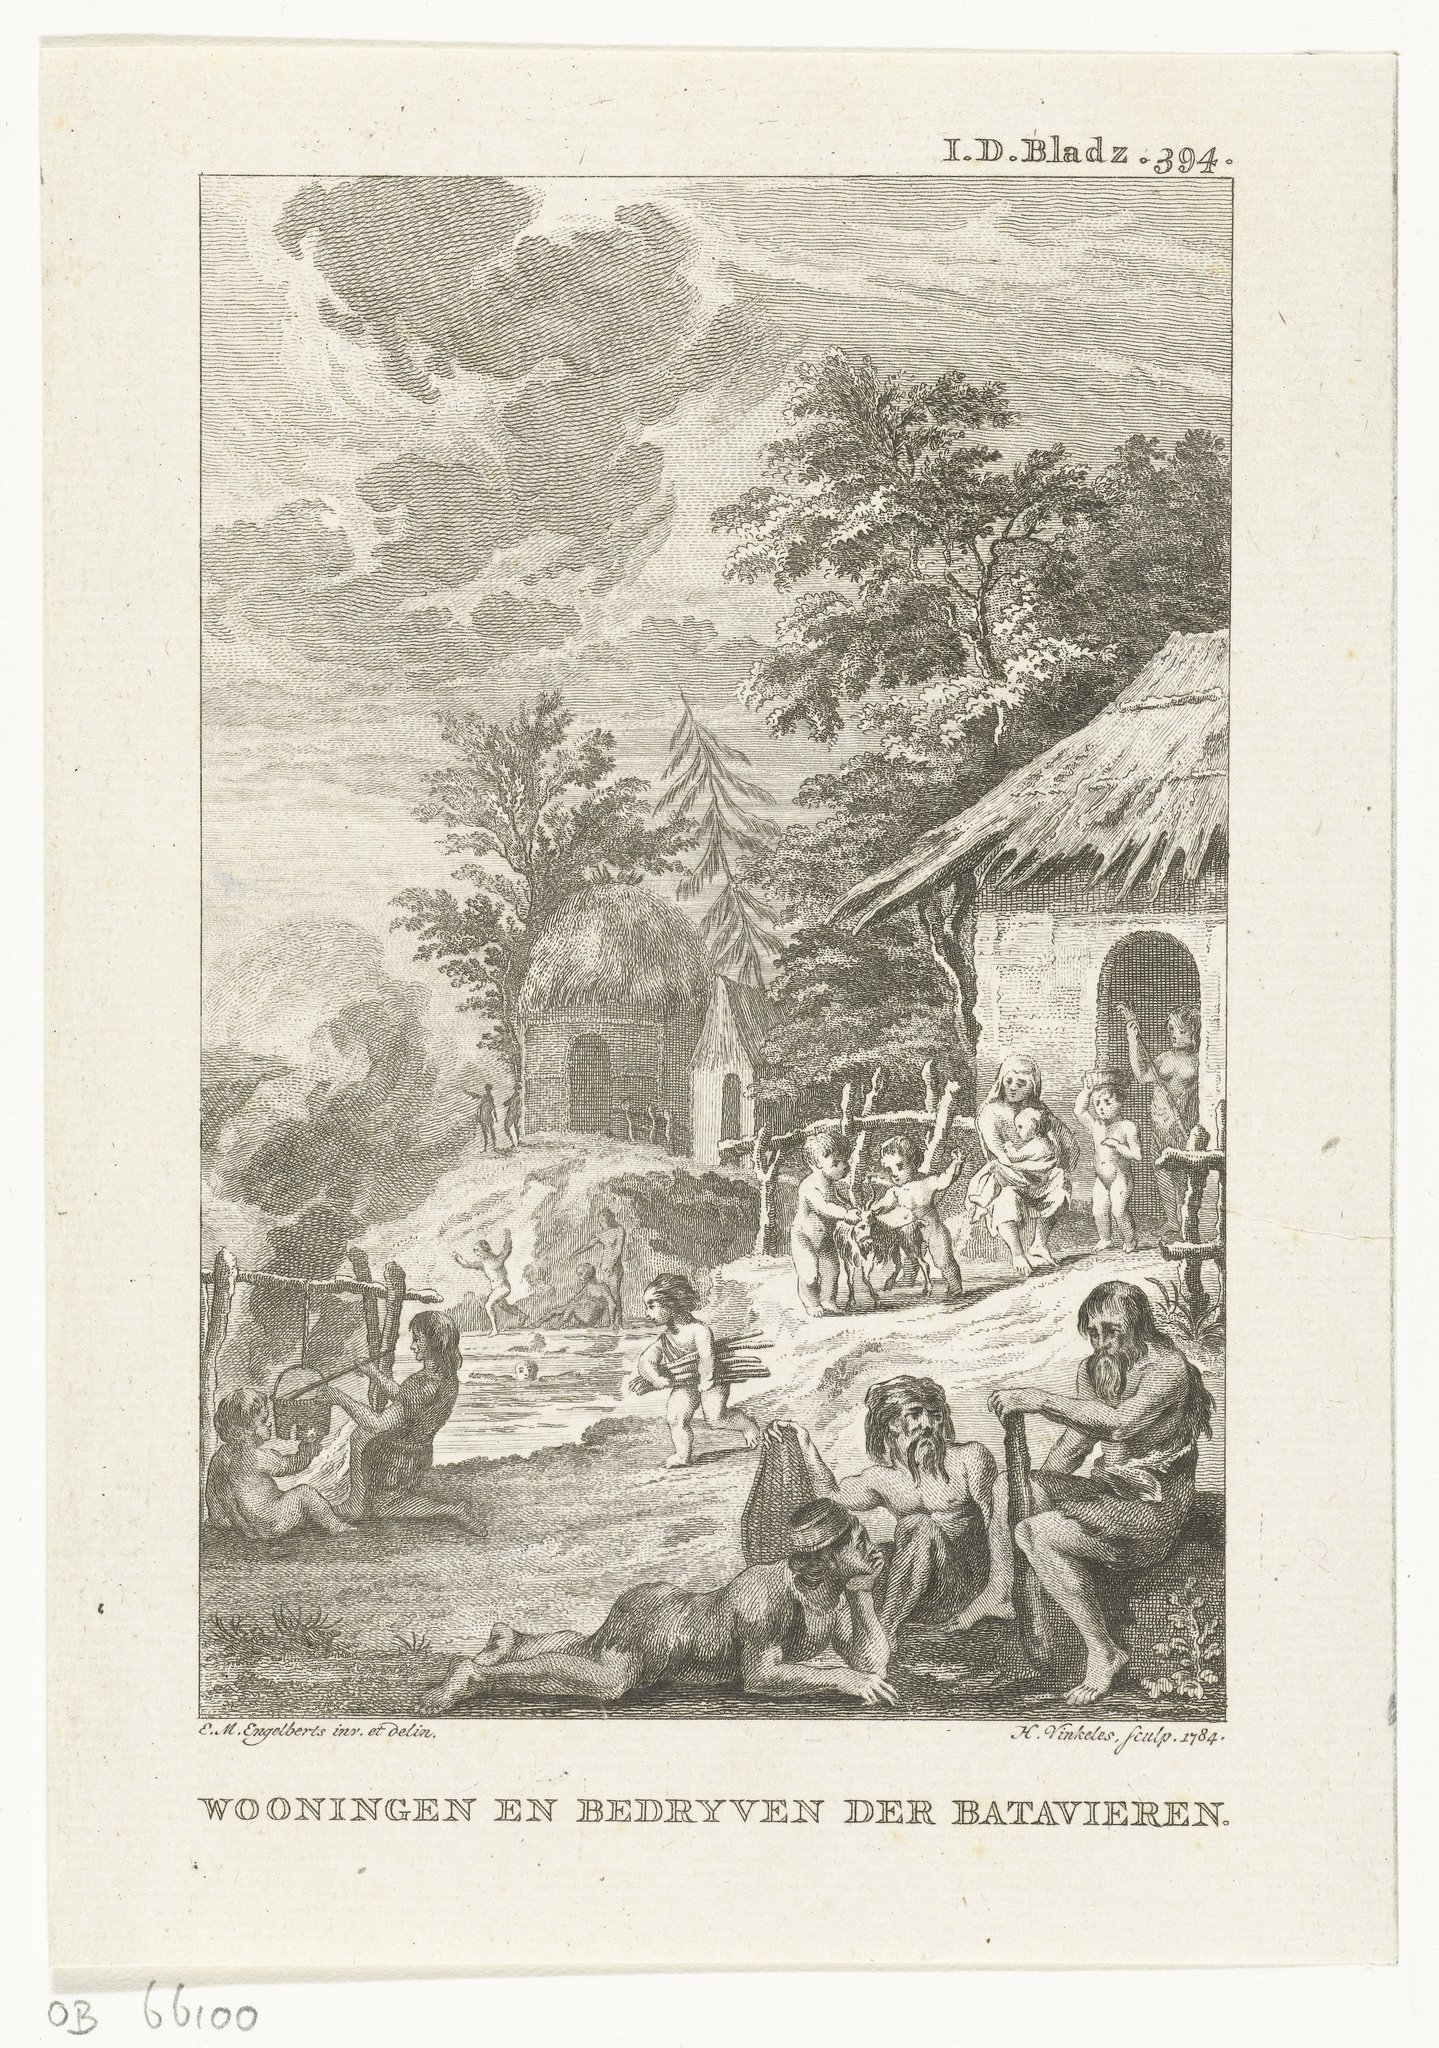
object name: history print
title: Wooningen en Bedryven der Batavieren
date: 1784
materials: paper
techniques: etching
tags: extinct, 'historical' peoples (with name), netherlands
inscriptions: collector's mark: Lugt 2228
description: Prent gebruikt als boekillustratie in: Engelberts, Engelbertus Matthias. De aloude staat en geschiedenissen der Vereenigde Nederlanden. Amsterdam: Johannes Allart, 1784-1799. Deel I, 1784.